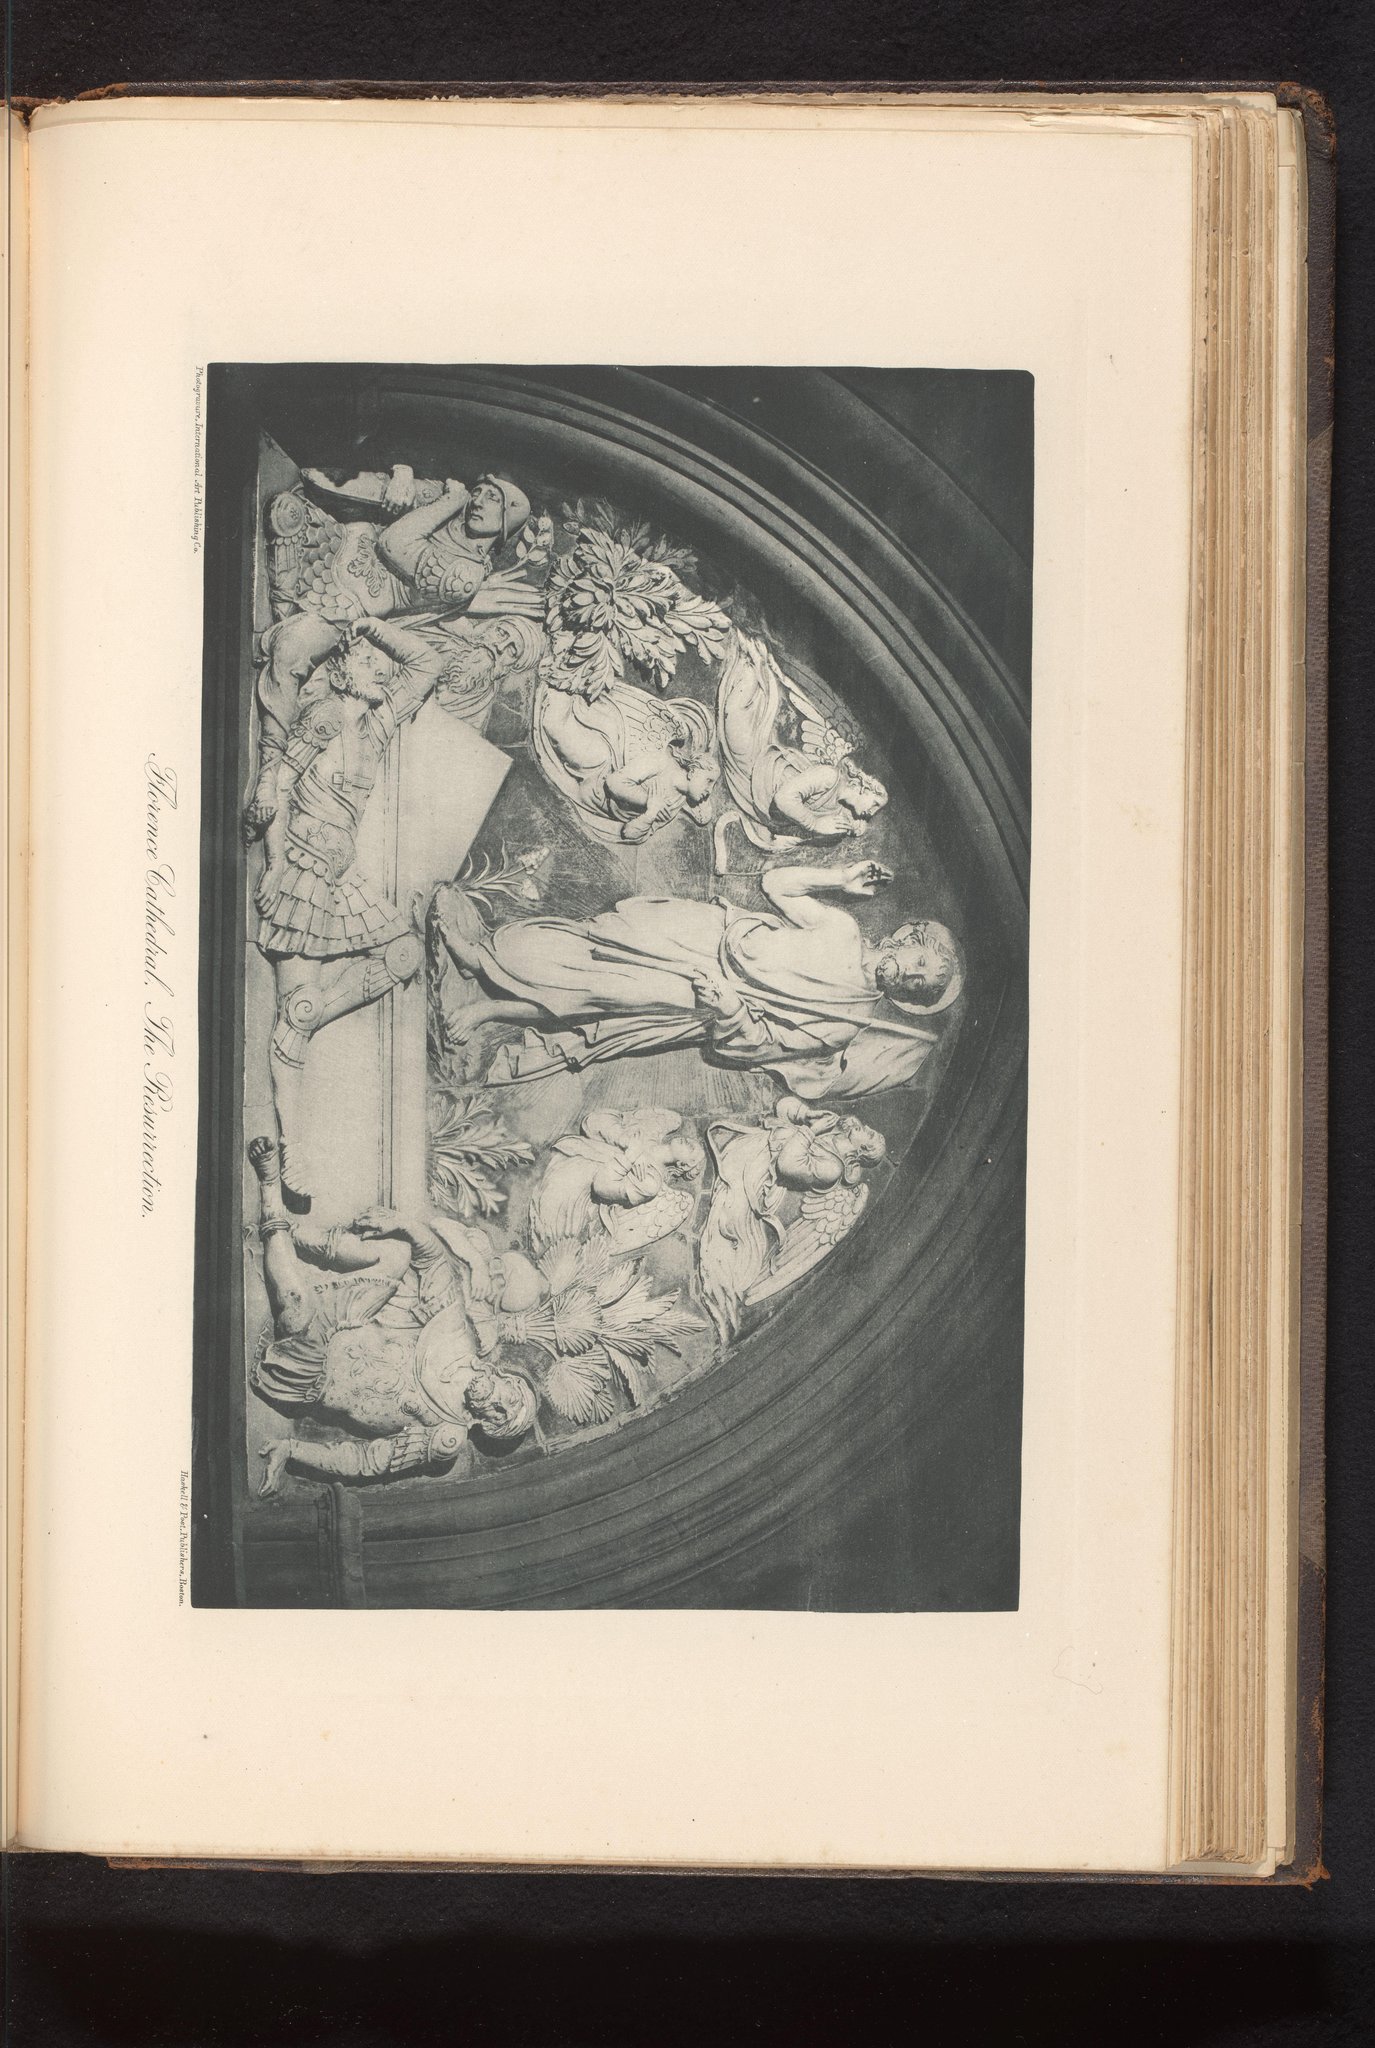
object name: page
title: Reliëf van de opstanding van Christus in de kathedraal van Florence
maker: Anonymous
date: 1881-1886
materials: paper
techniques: photograph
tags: christ, usually holding a banner, arises from the grave; often combined with sleeping and/or frightened soldiers, sculpture (+ relief ~ sculpture)